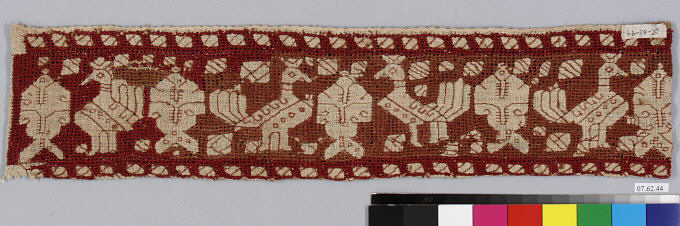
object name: border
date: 1601-1700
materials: linen, silk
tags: birds